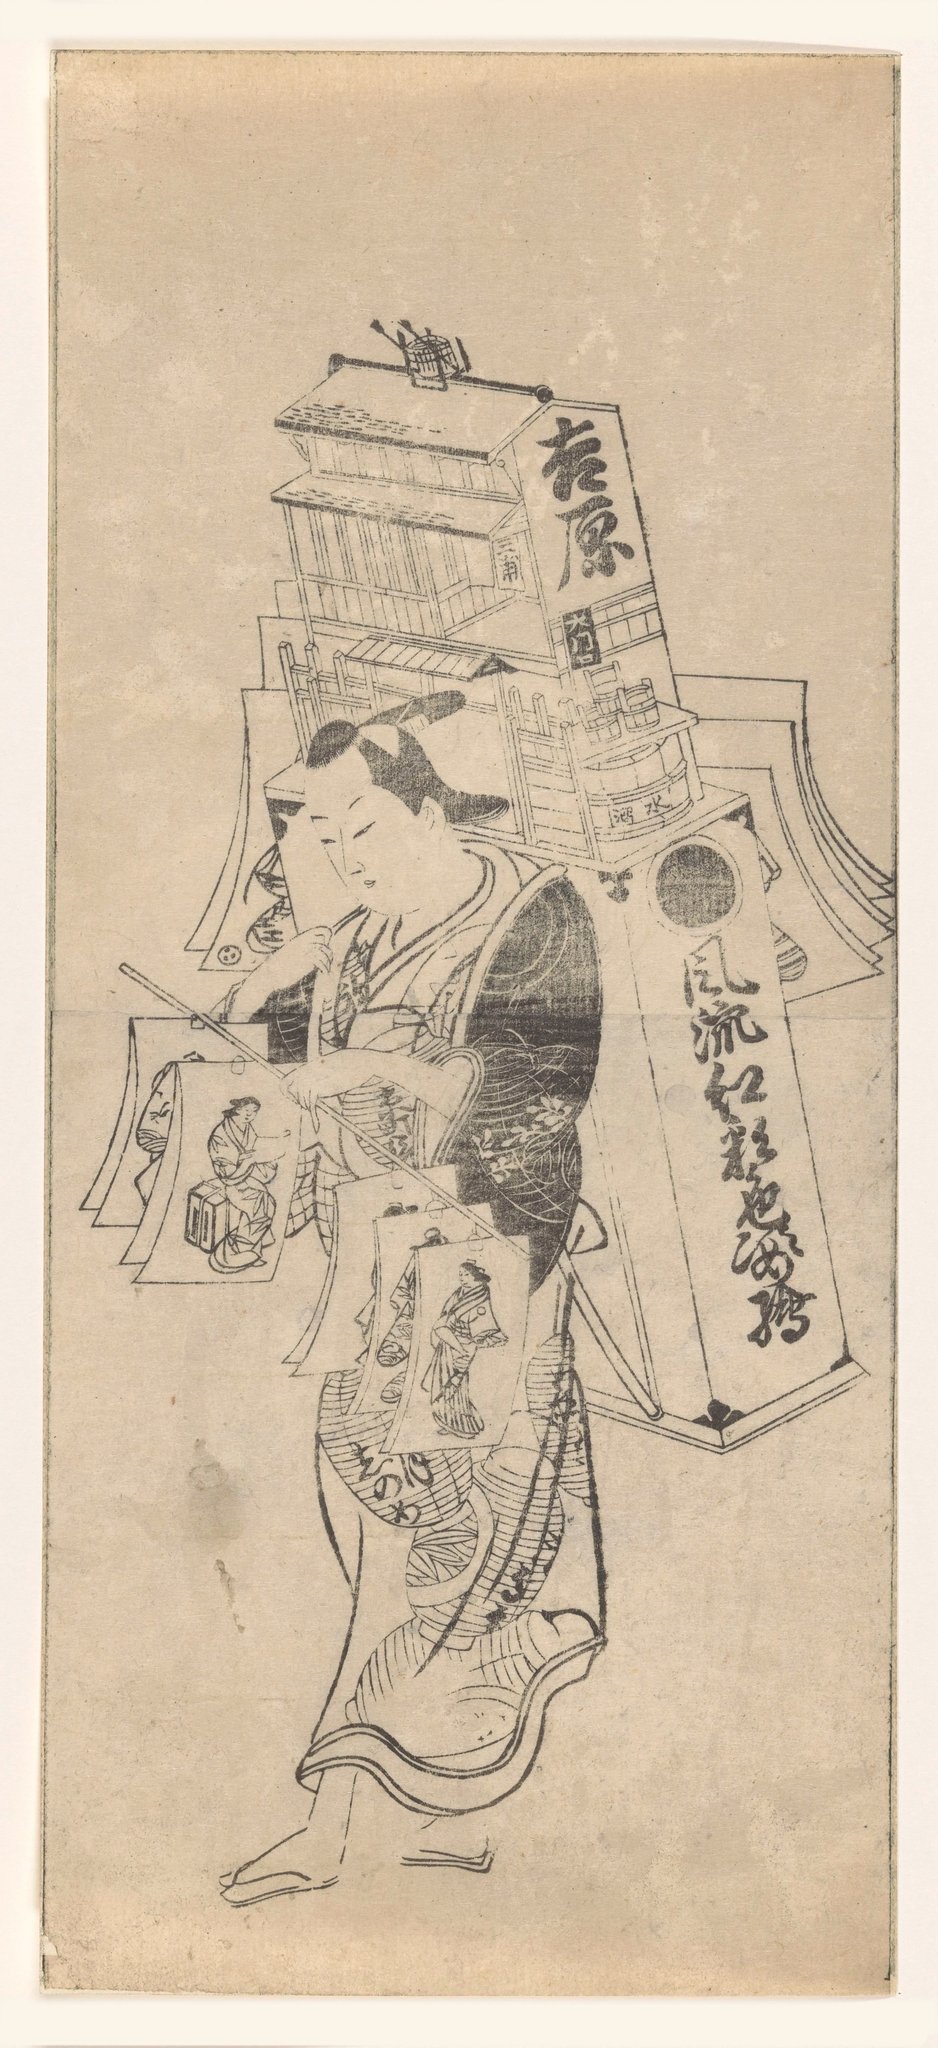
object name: print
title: Rondreizende Japanse prenthandelaar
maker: Anonymous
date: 1850-1900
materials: paper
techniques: woodcut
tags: print, e.g.: engraving, etching, lithograph, book, japanese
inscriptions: collector's mark: Lugt 2228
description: Een rondreizende Japanse prenthandelaar met in zijn linkerhand een stok met prenten, op zijn rug een voorraadkist met bovenop een model van een huis.